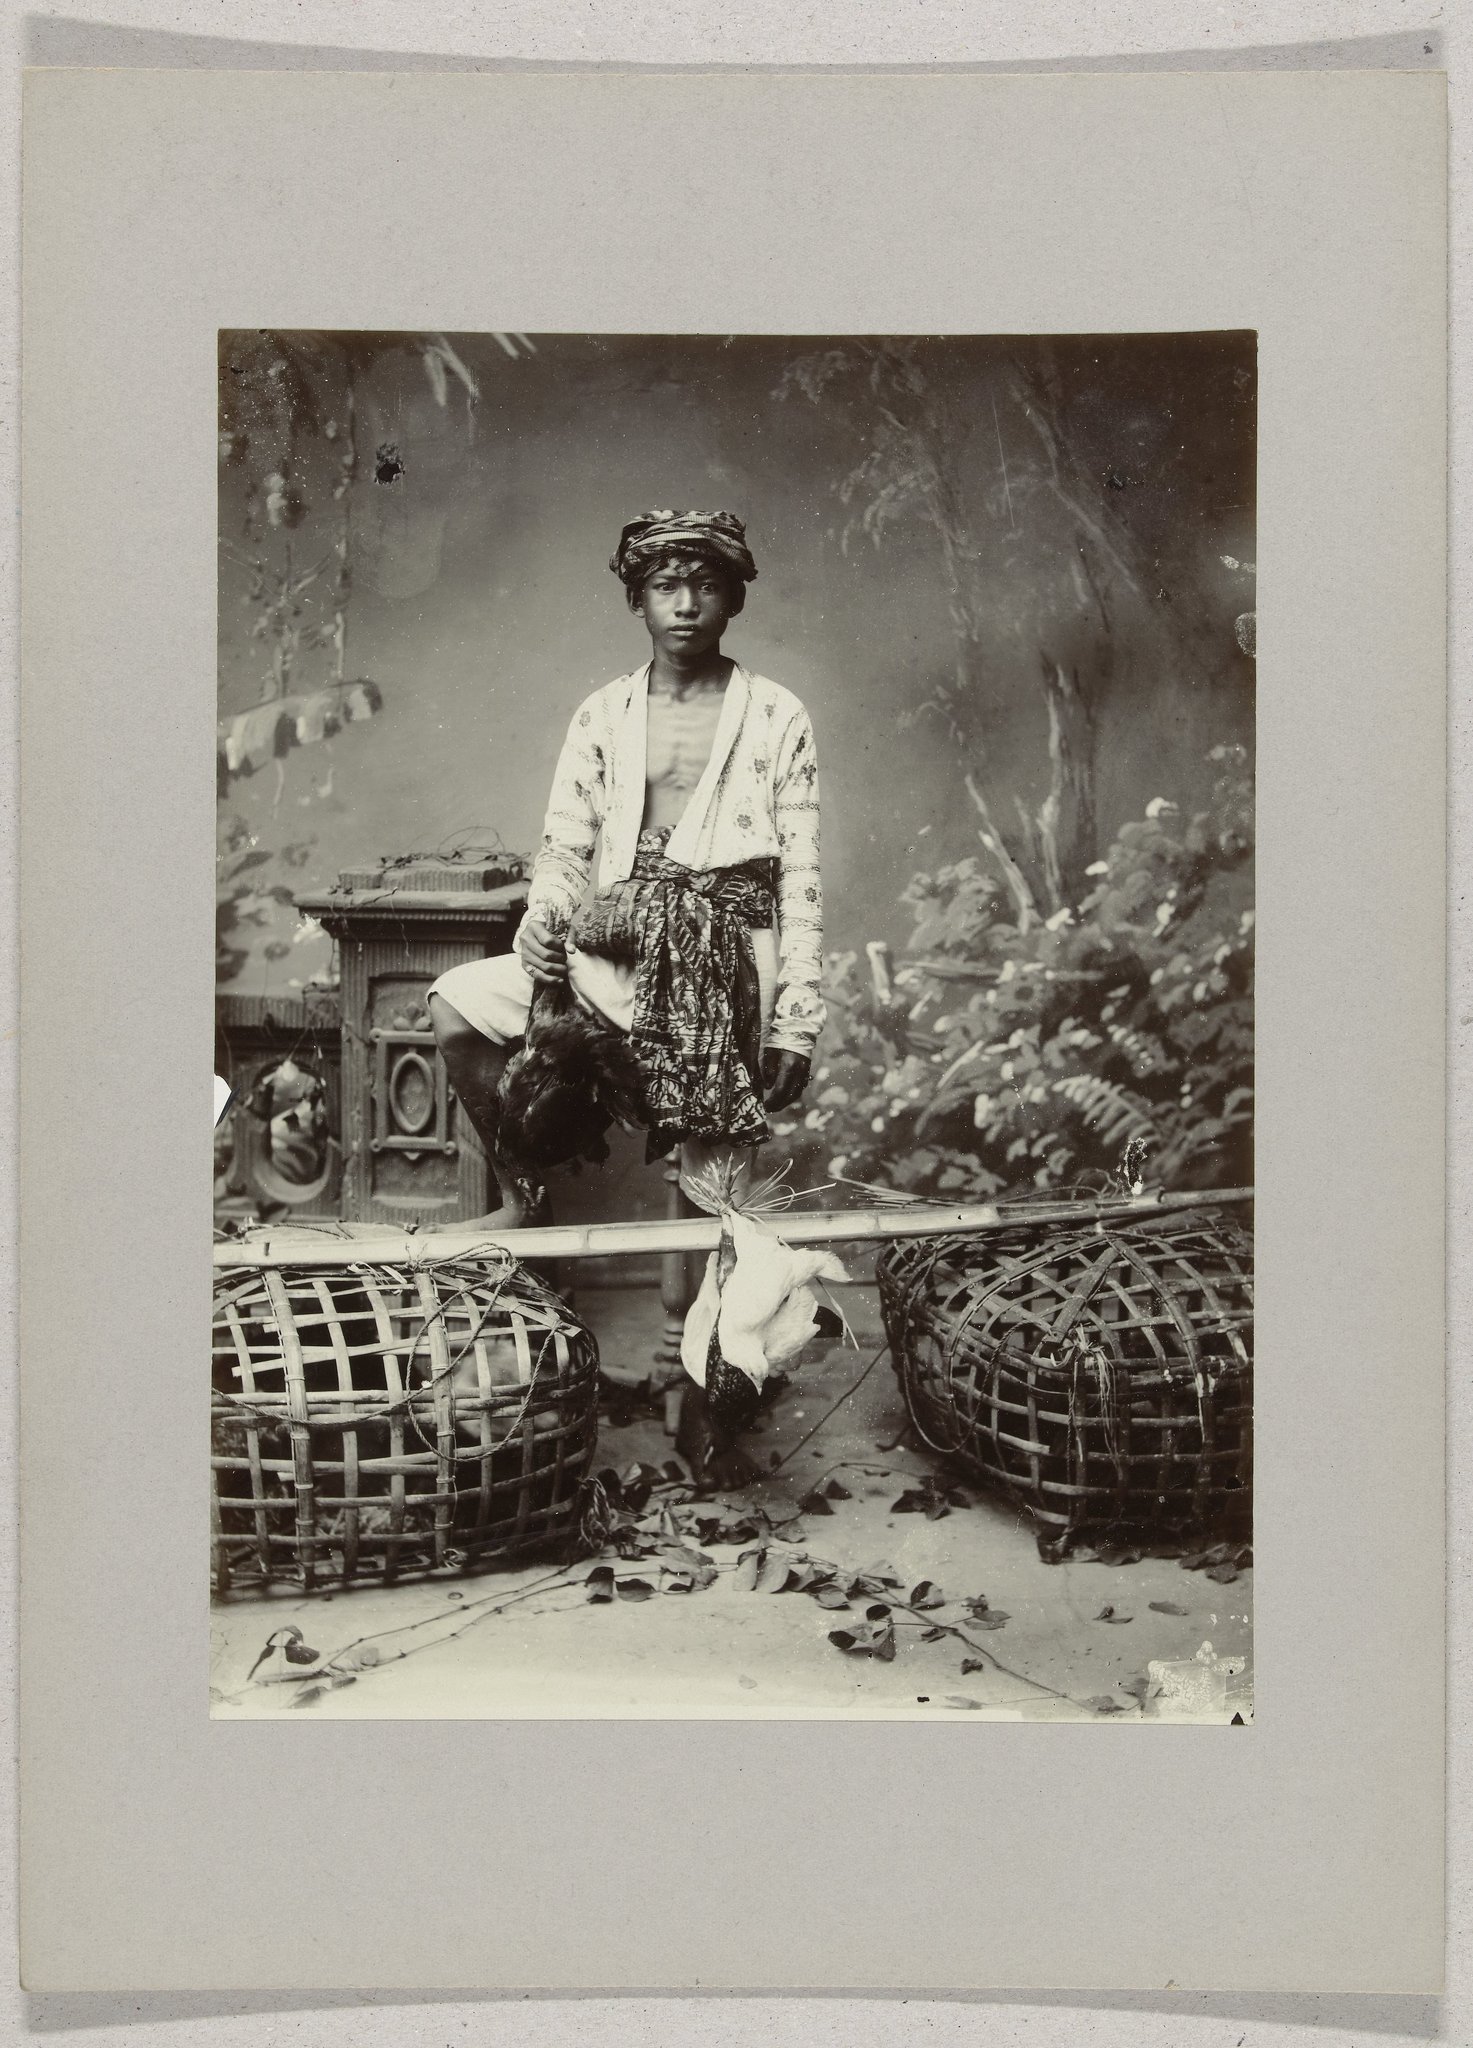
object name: photograph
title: Studioportret met jongen met kippen in Nederlands-Indië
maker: Anonymous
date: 1895-1915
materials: cardboard, paper, photographic support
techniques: gelatin silver print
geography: dutch east indies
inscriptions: number: ‘21’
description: Jongen met kippen voor een geschilderd decor, Nederlands-Indië